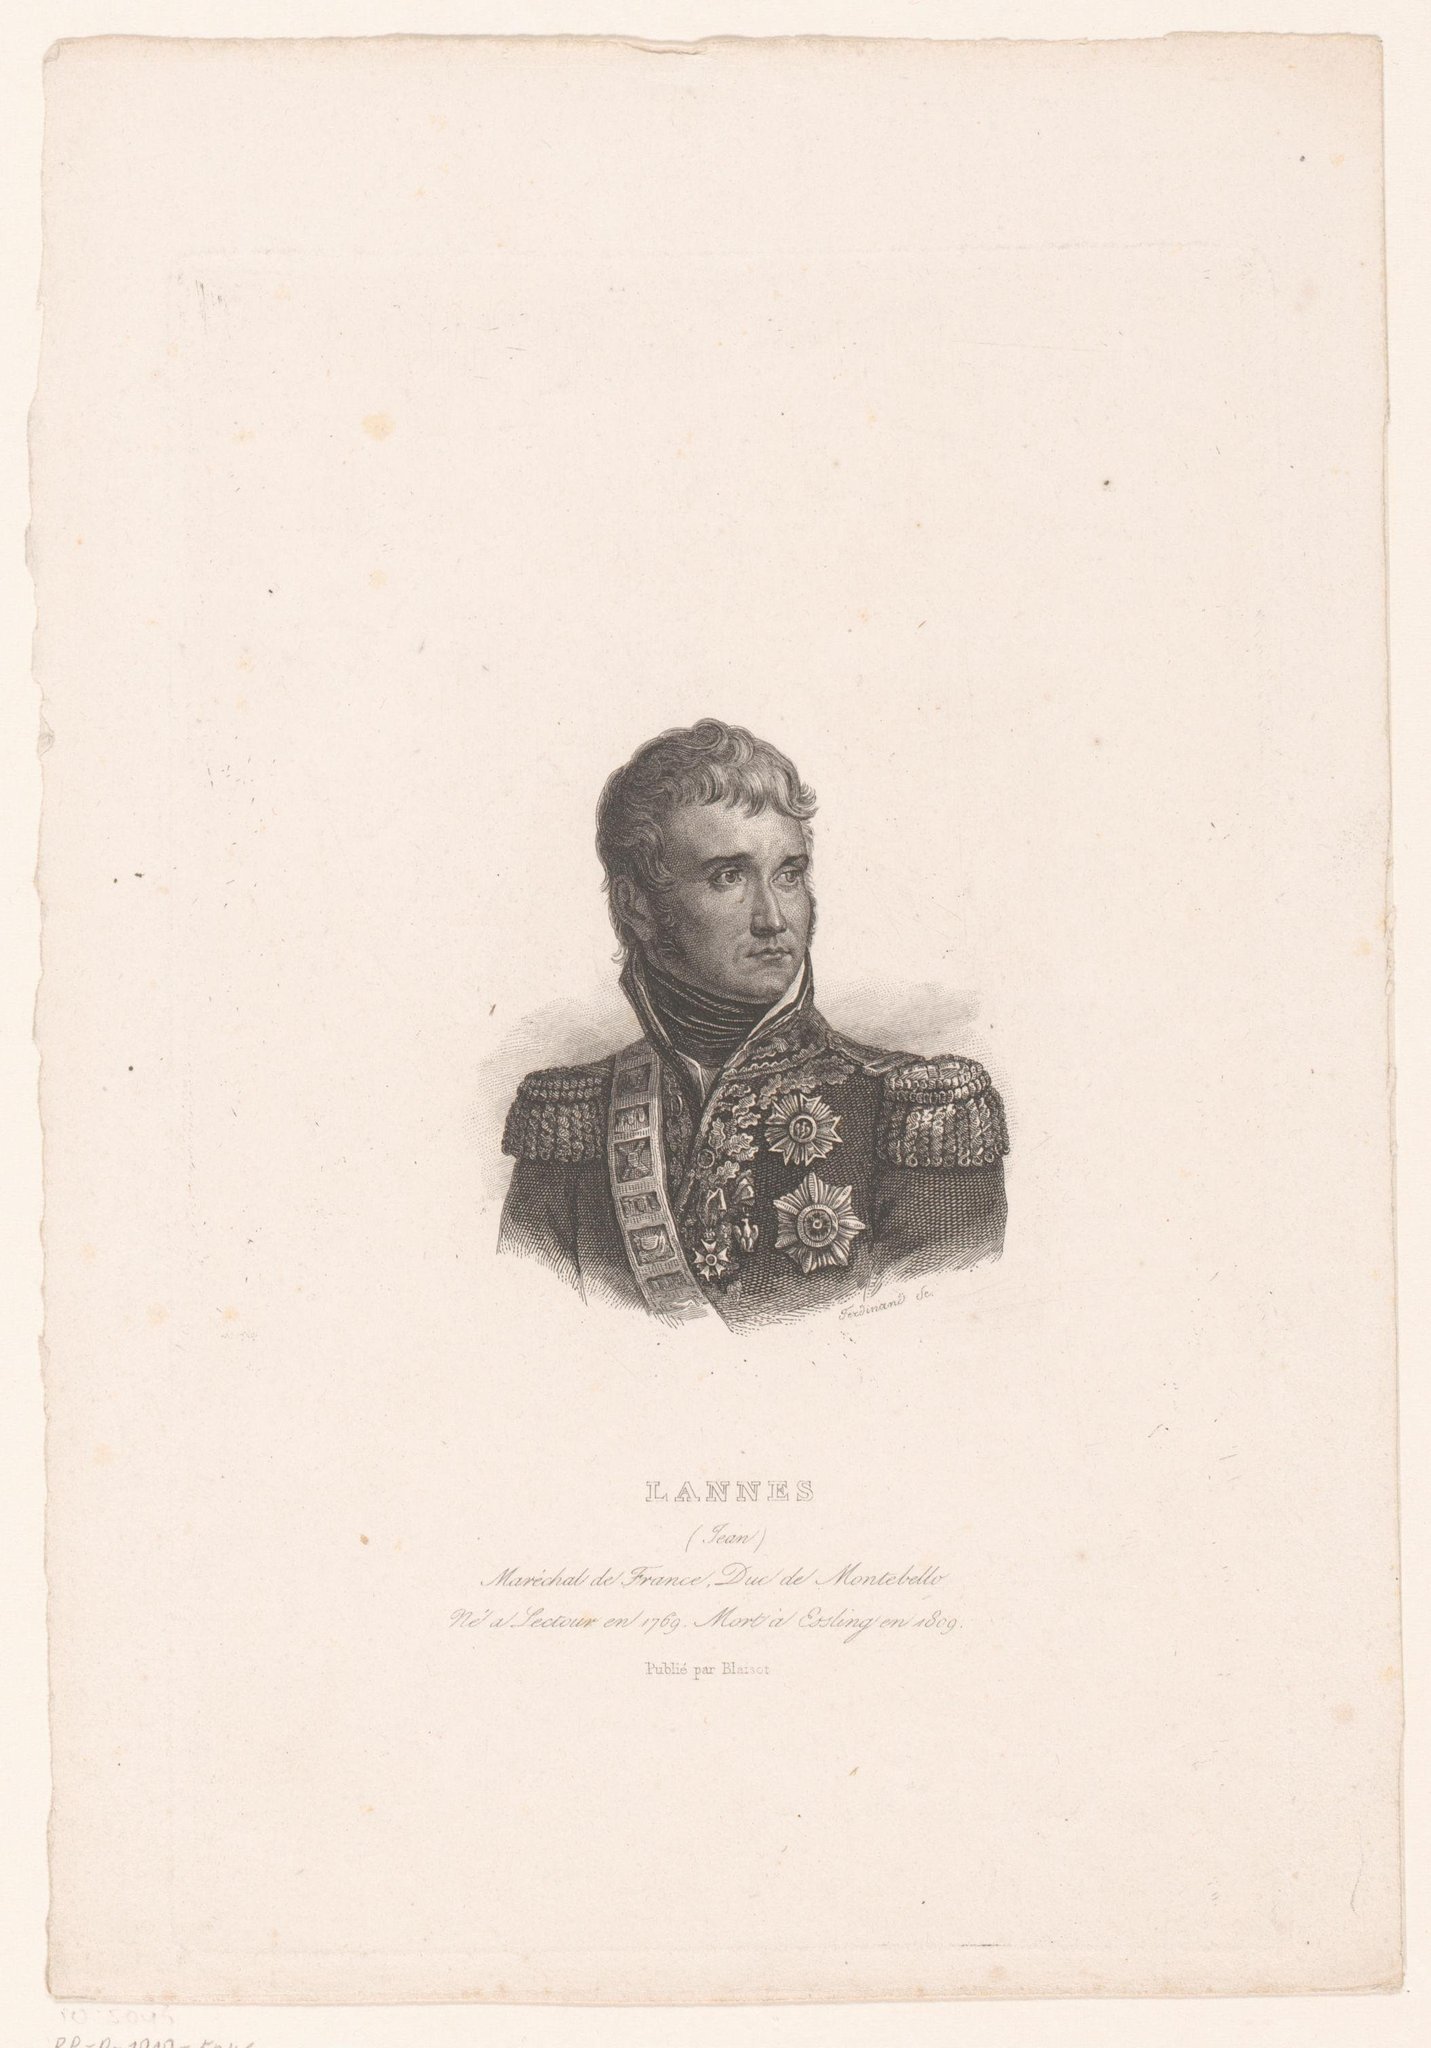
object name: print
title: Lannes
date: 1800-1900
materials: paper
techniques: engraving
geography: paris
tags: historical persons, nobility and patriciate; chivalry, knighthood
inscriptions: collector's mark: Lugt 2228